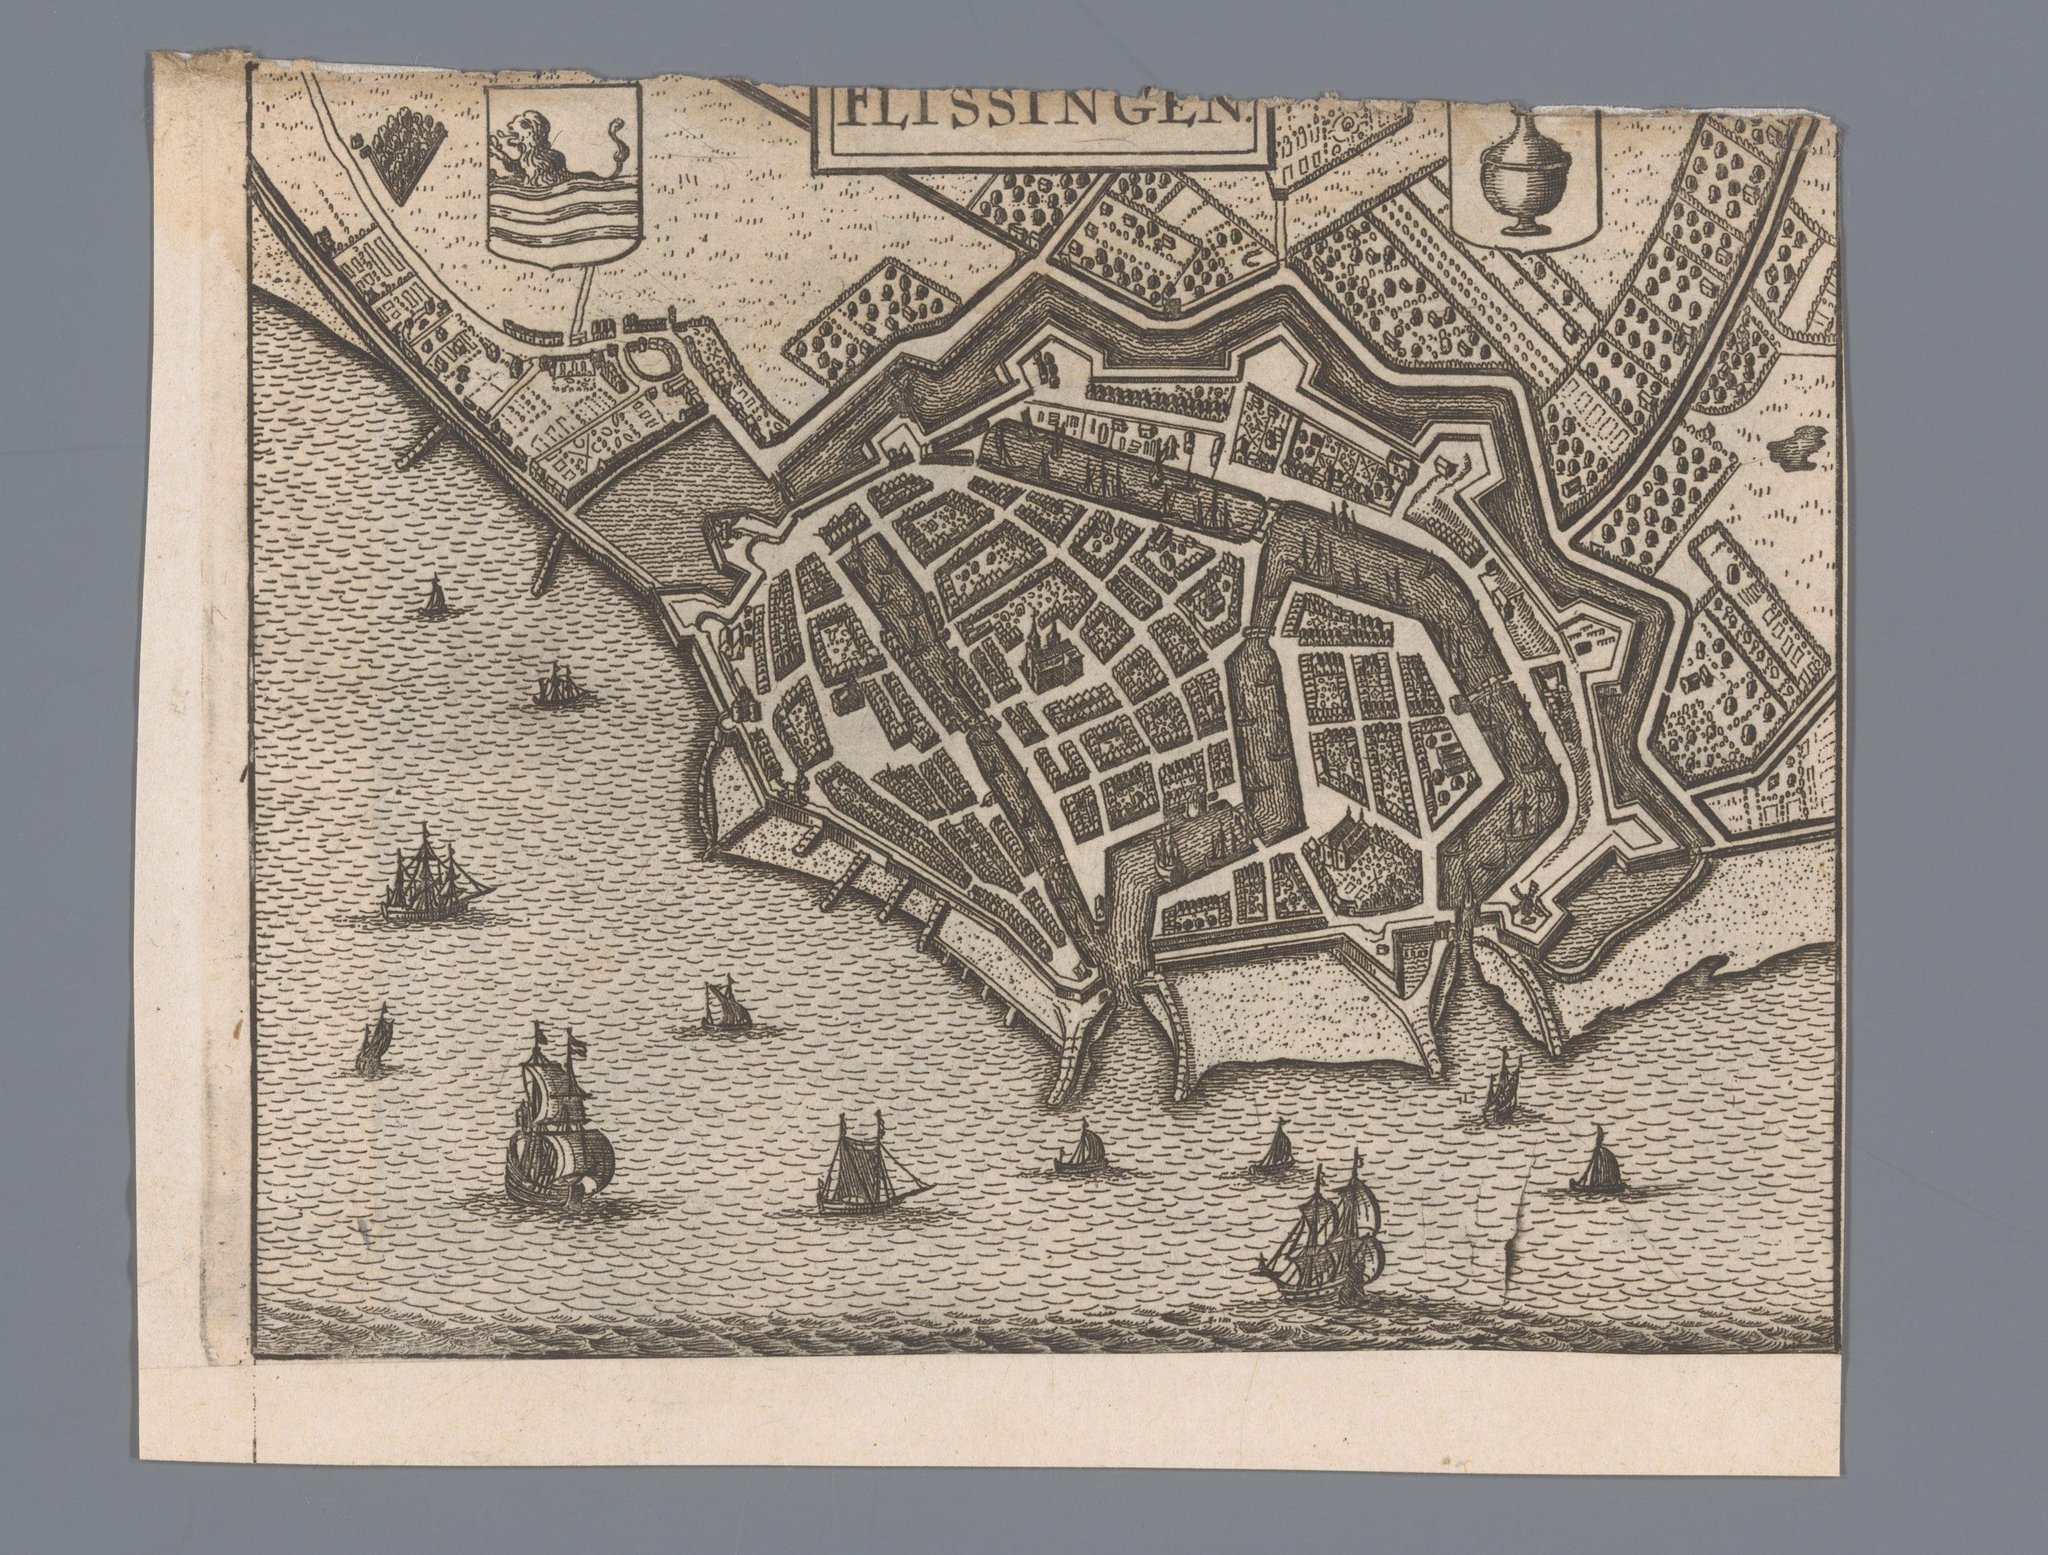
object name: area plan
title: Flissingen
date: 1652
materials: paper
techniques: etching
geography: netherlands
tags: maps of cities, flushing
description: Prent uit: Guicciardini, Lodovico. Belgicae sive inferioris Germaniae Descriptio (...). Amsterdam: Johannes Janssonius, 1652, dl. 3, p. 181.